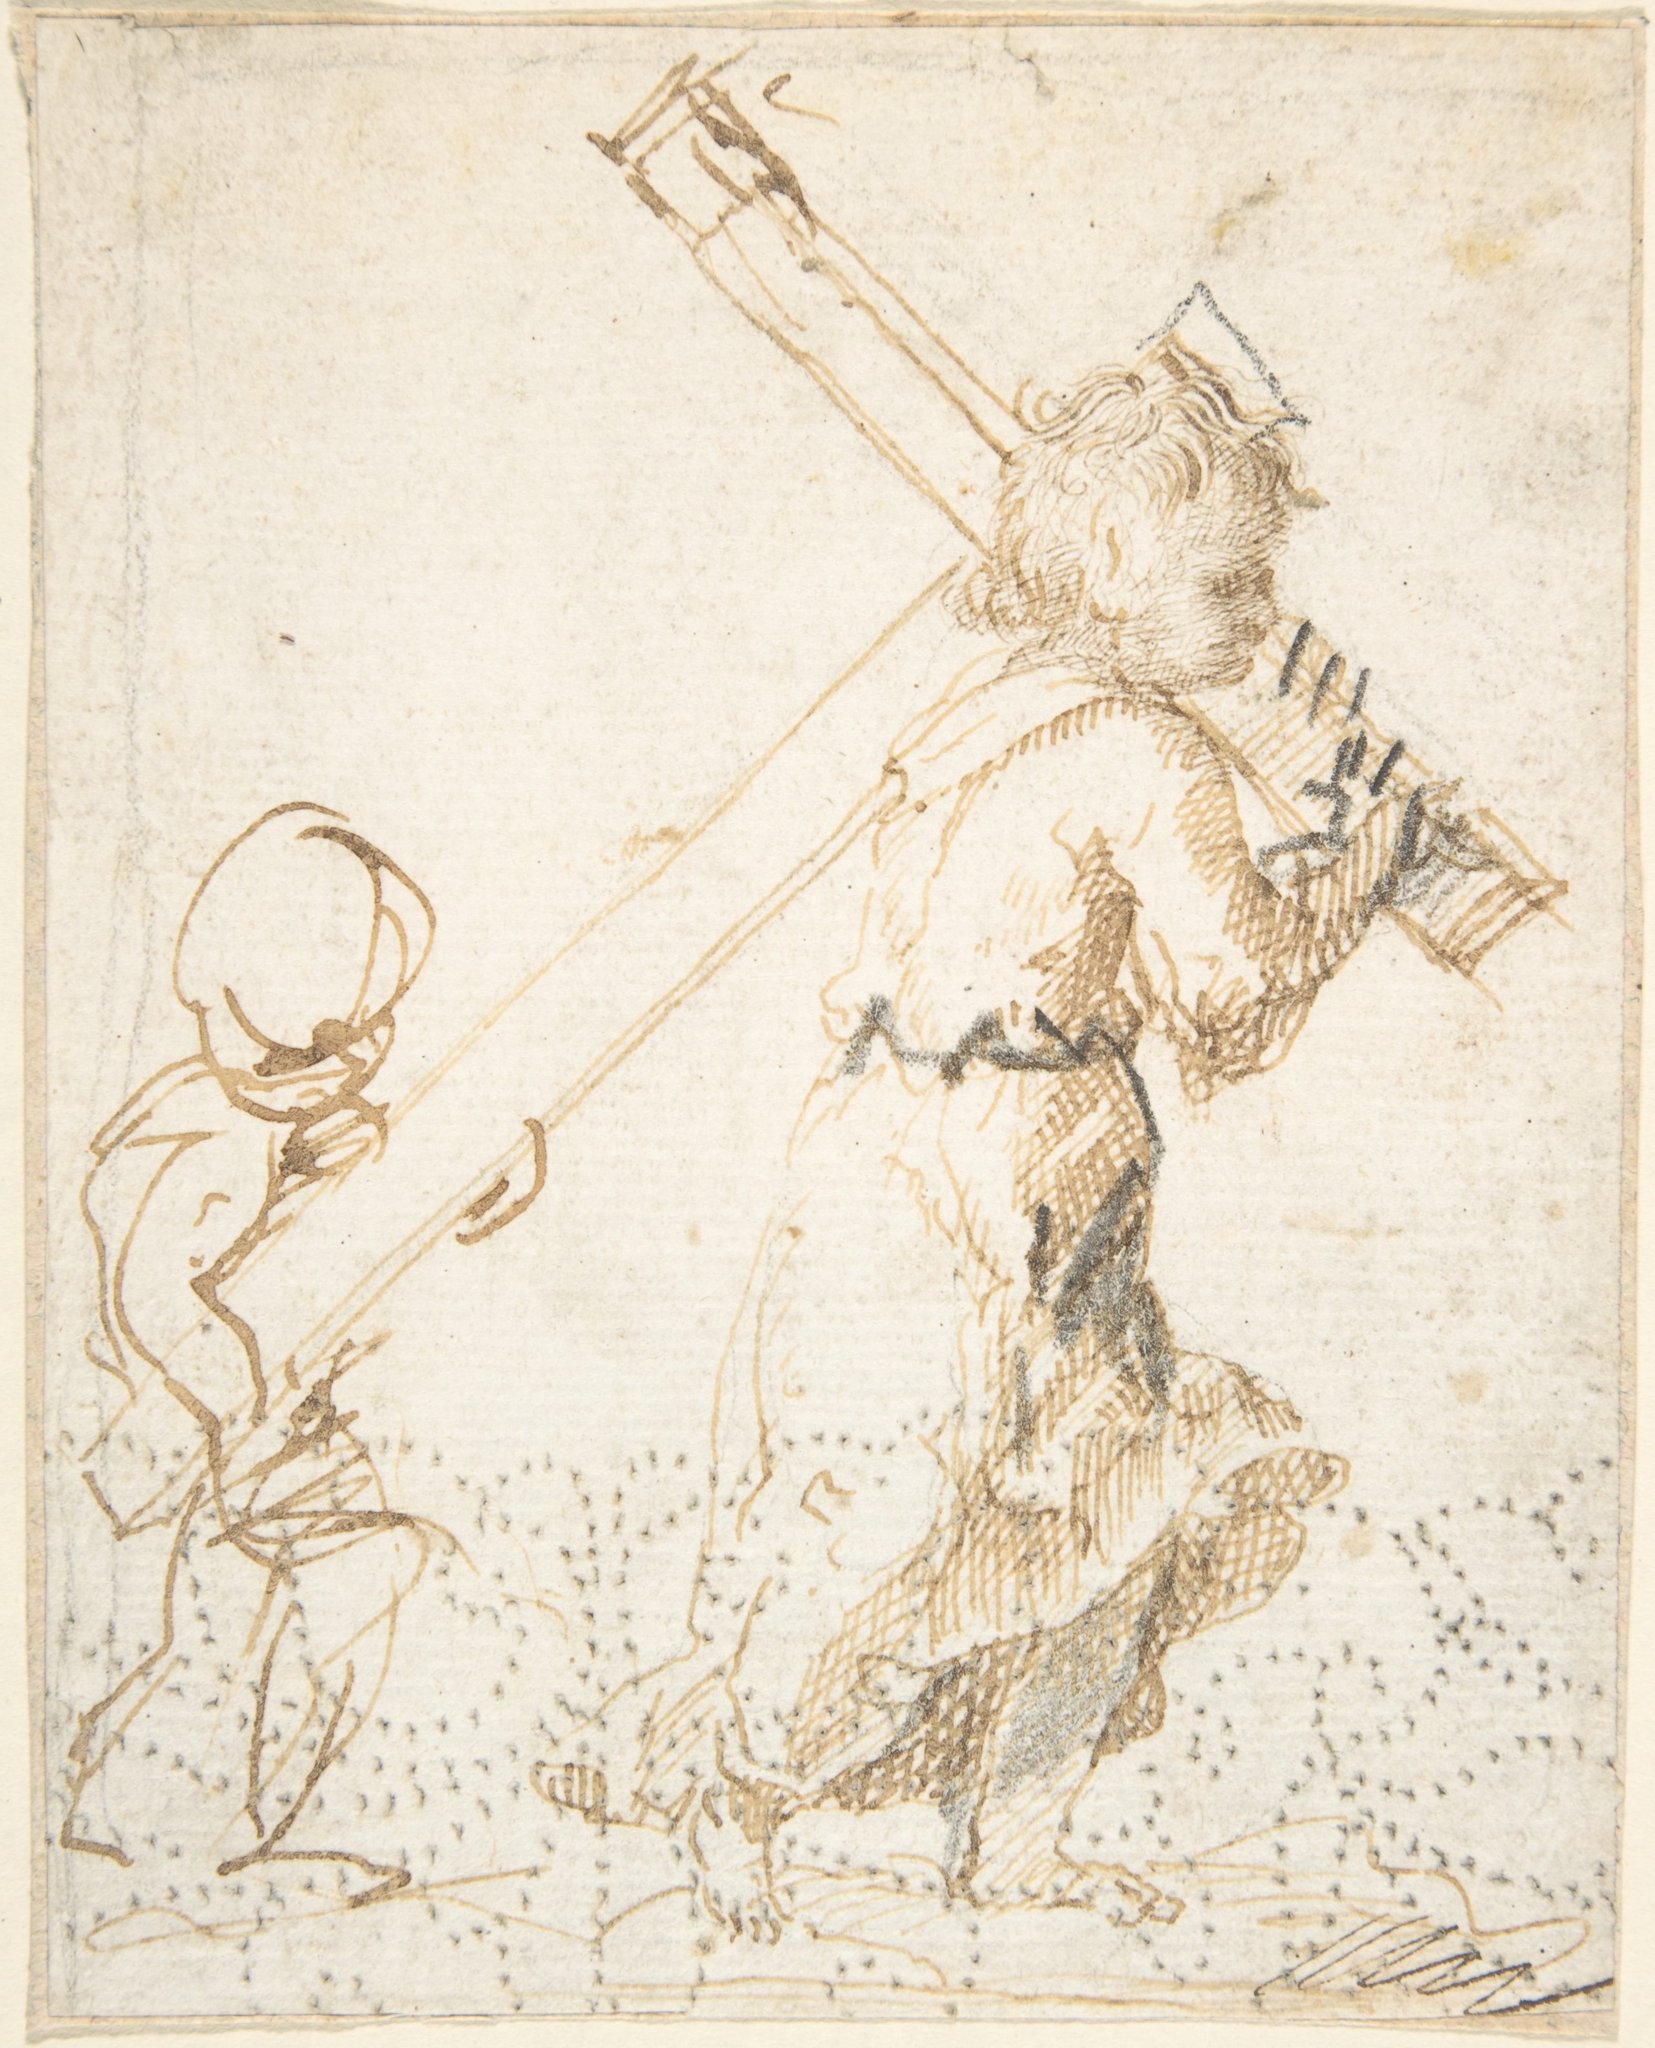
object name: drawing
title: Christ Child and Secondary Child Figure Bearing the Cross (recto); Fragment of Design for Ornamental Border (verso)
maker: anonymous, spanish, school of seville, 17th century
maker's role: artist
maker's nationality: spanish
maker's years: 1600-1700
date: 1601-1700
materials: chalk, ink, paper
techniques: drawing, pen, transfer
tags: christ,cross